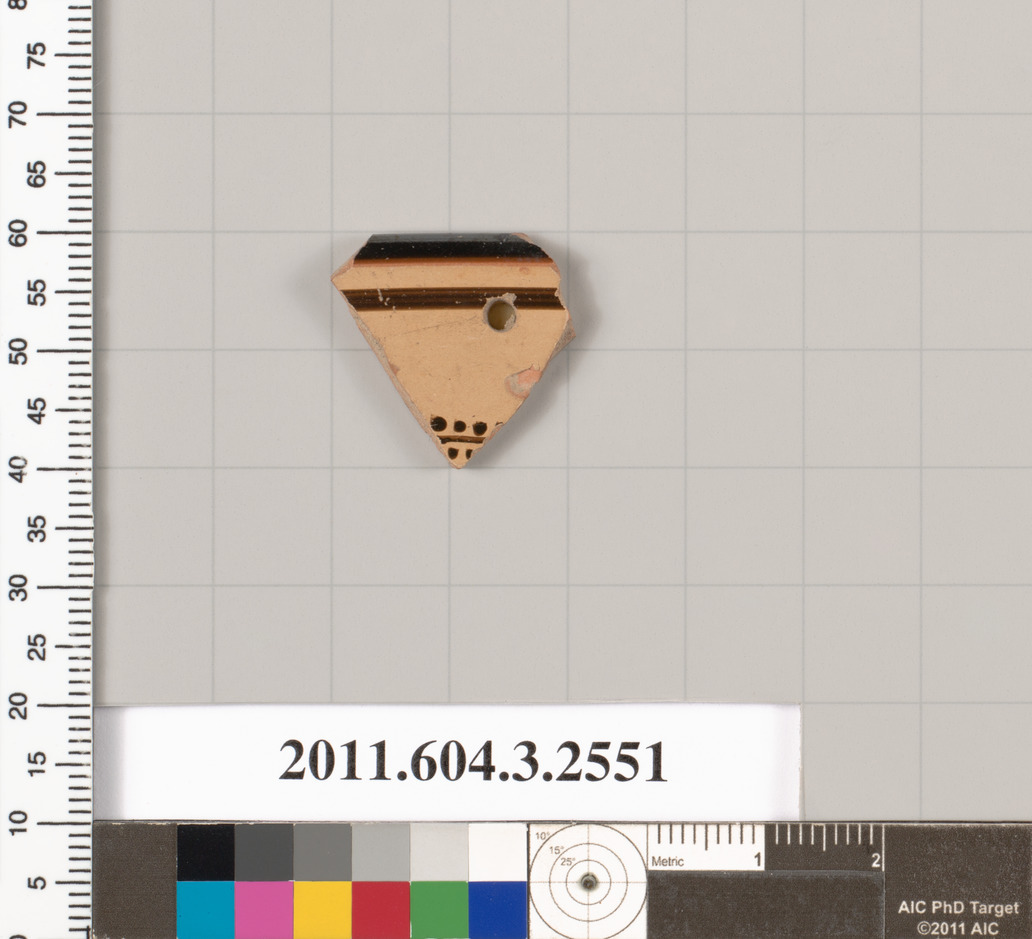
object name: kylix fragment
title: Terracotta rim fragment of a kylix (drinking cup)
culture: greek, attic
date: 534-468 BCE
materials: terracotta